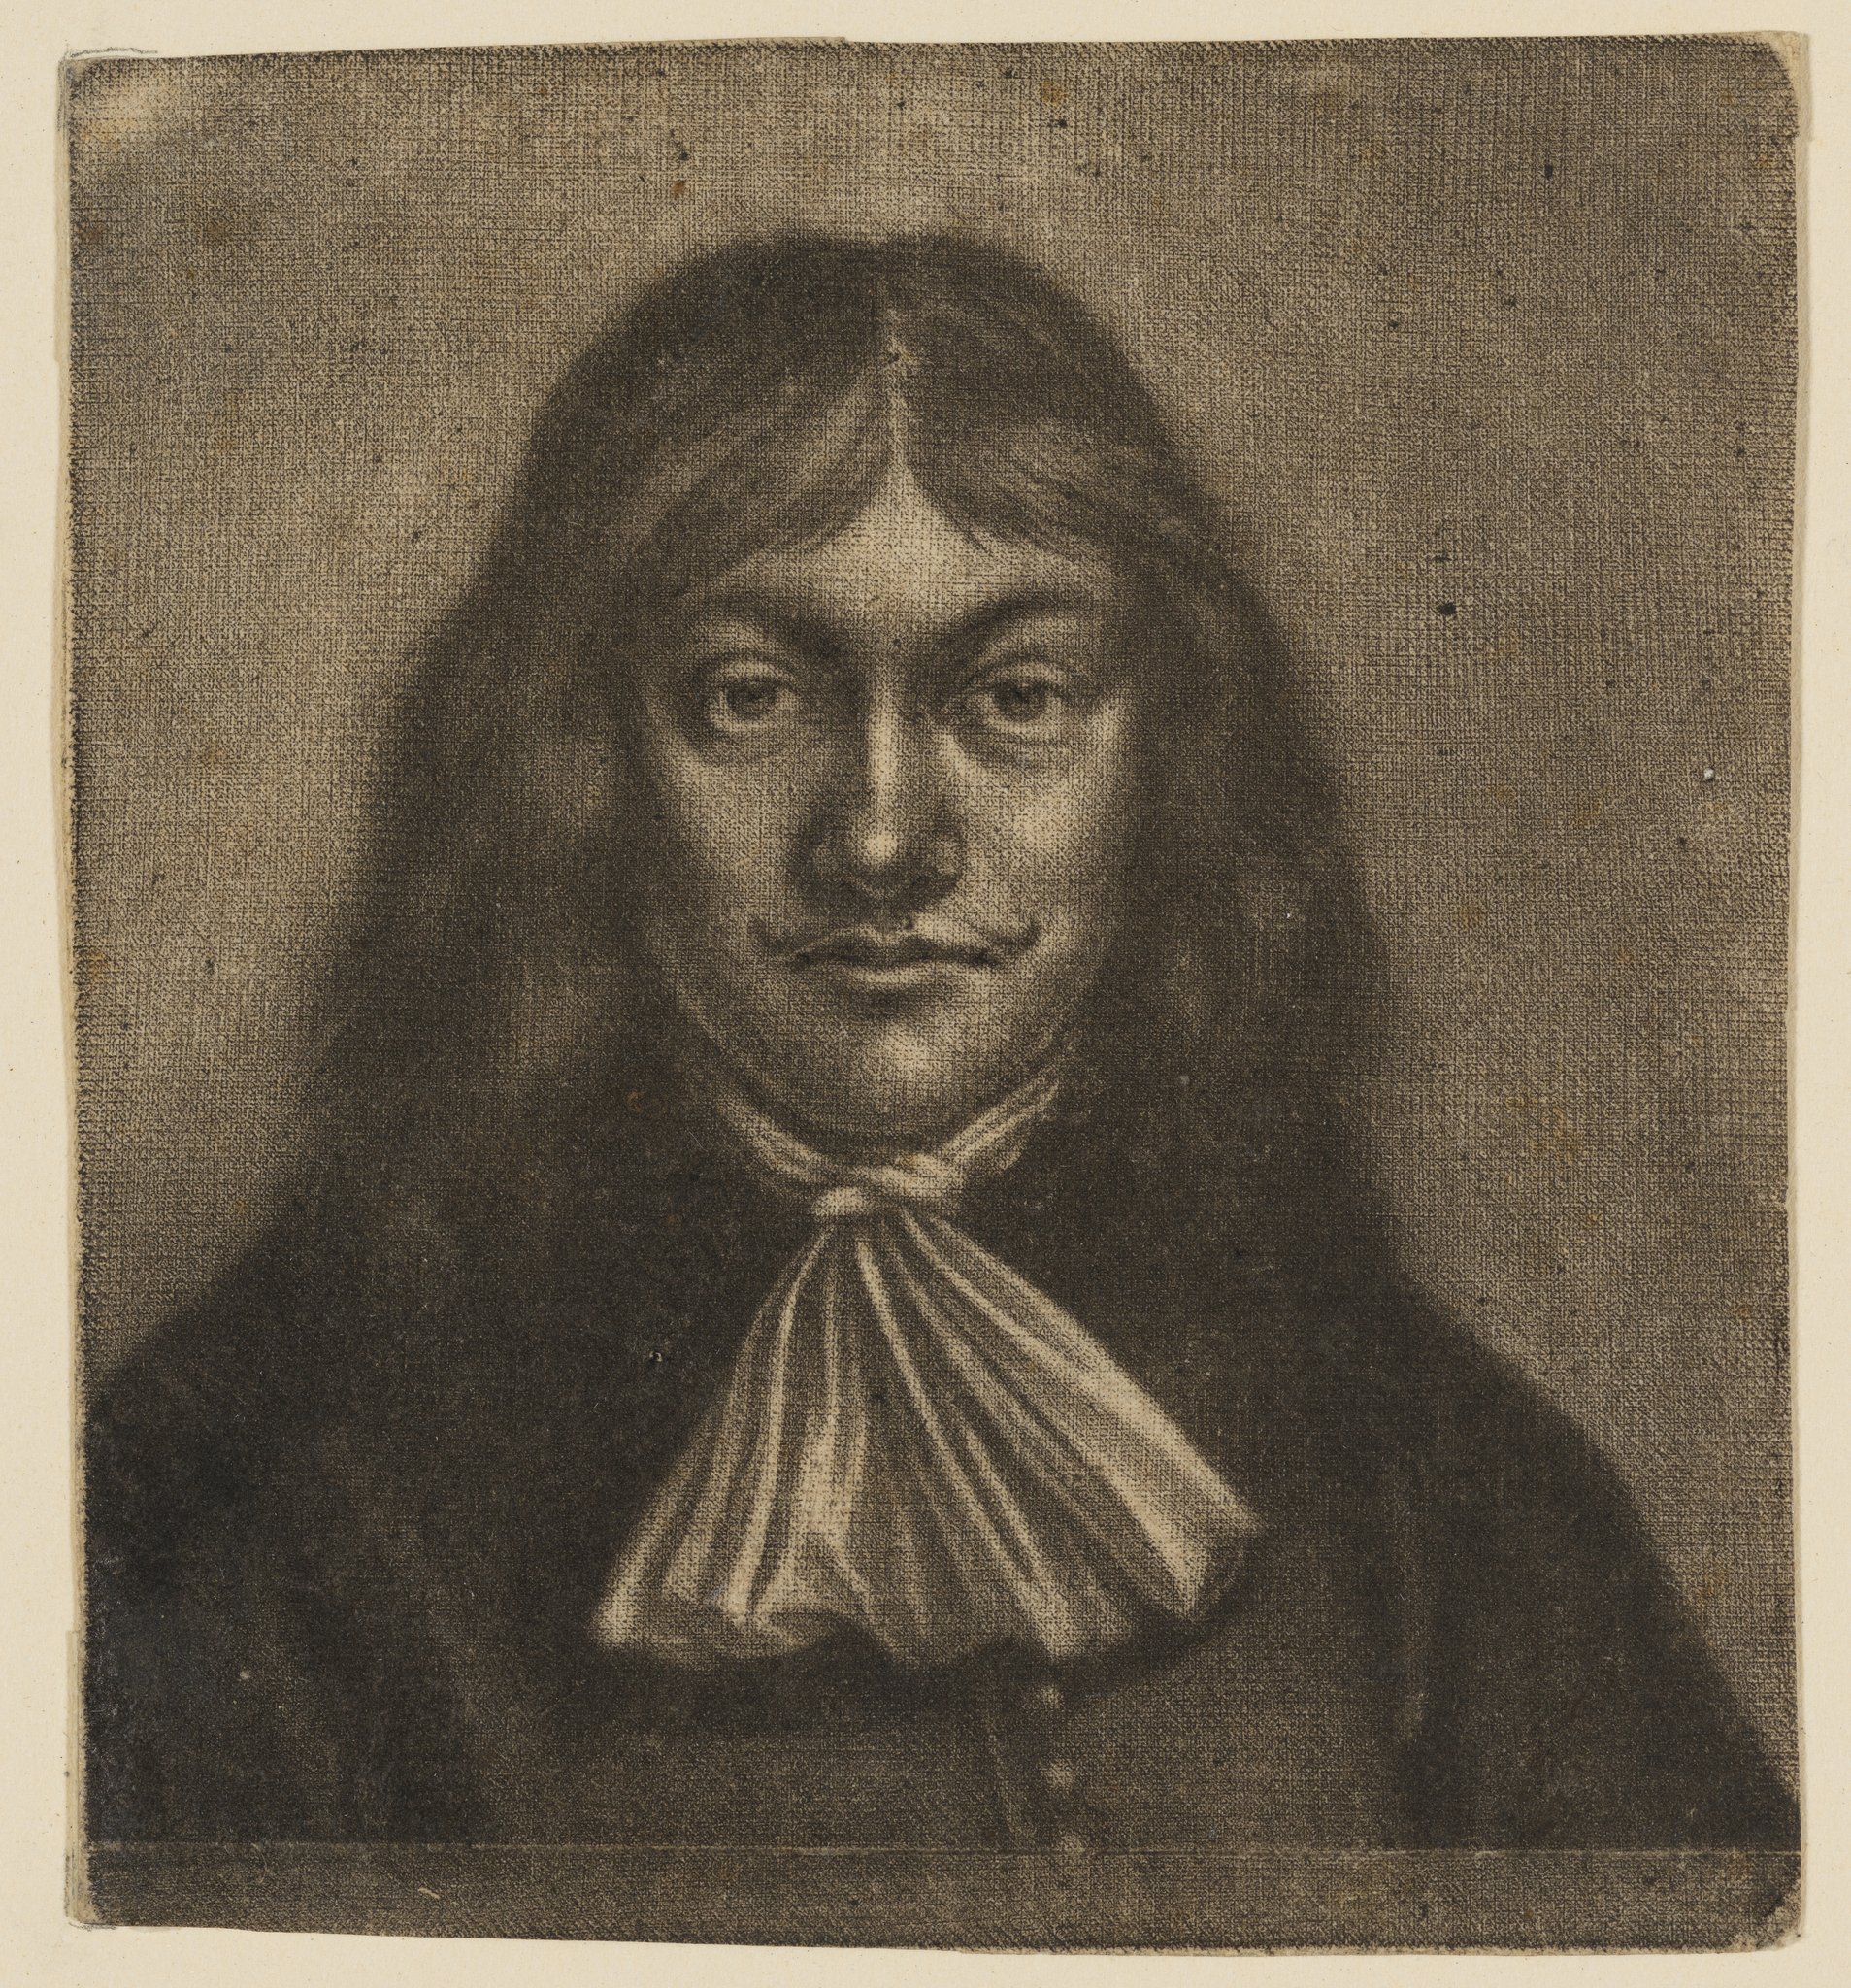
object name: print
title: Small Portrait of a Man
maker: wallerant vaillant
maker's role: artist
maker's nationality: dutch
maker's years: 1623-1677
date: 1634-1666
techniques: mezzotint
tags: men,portraits